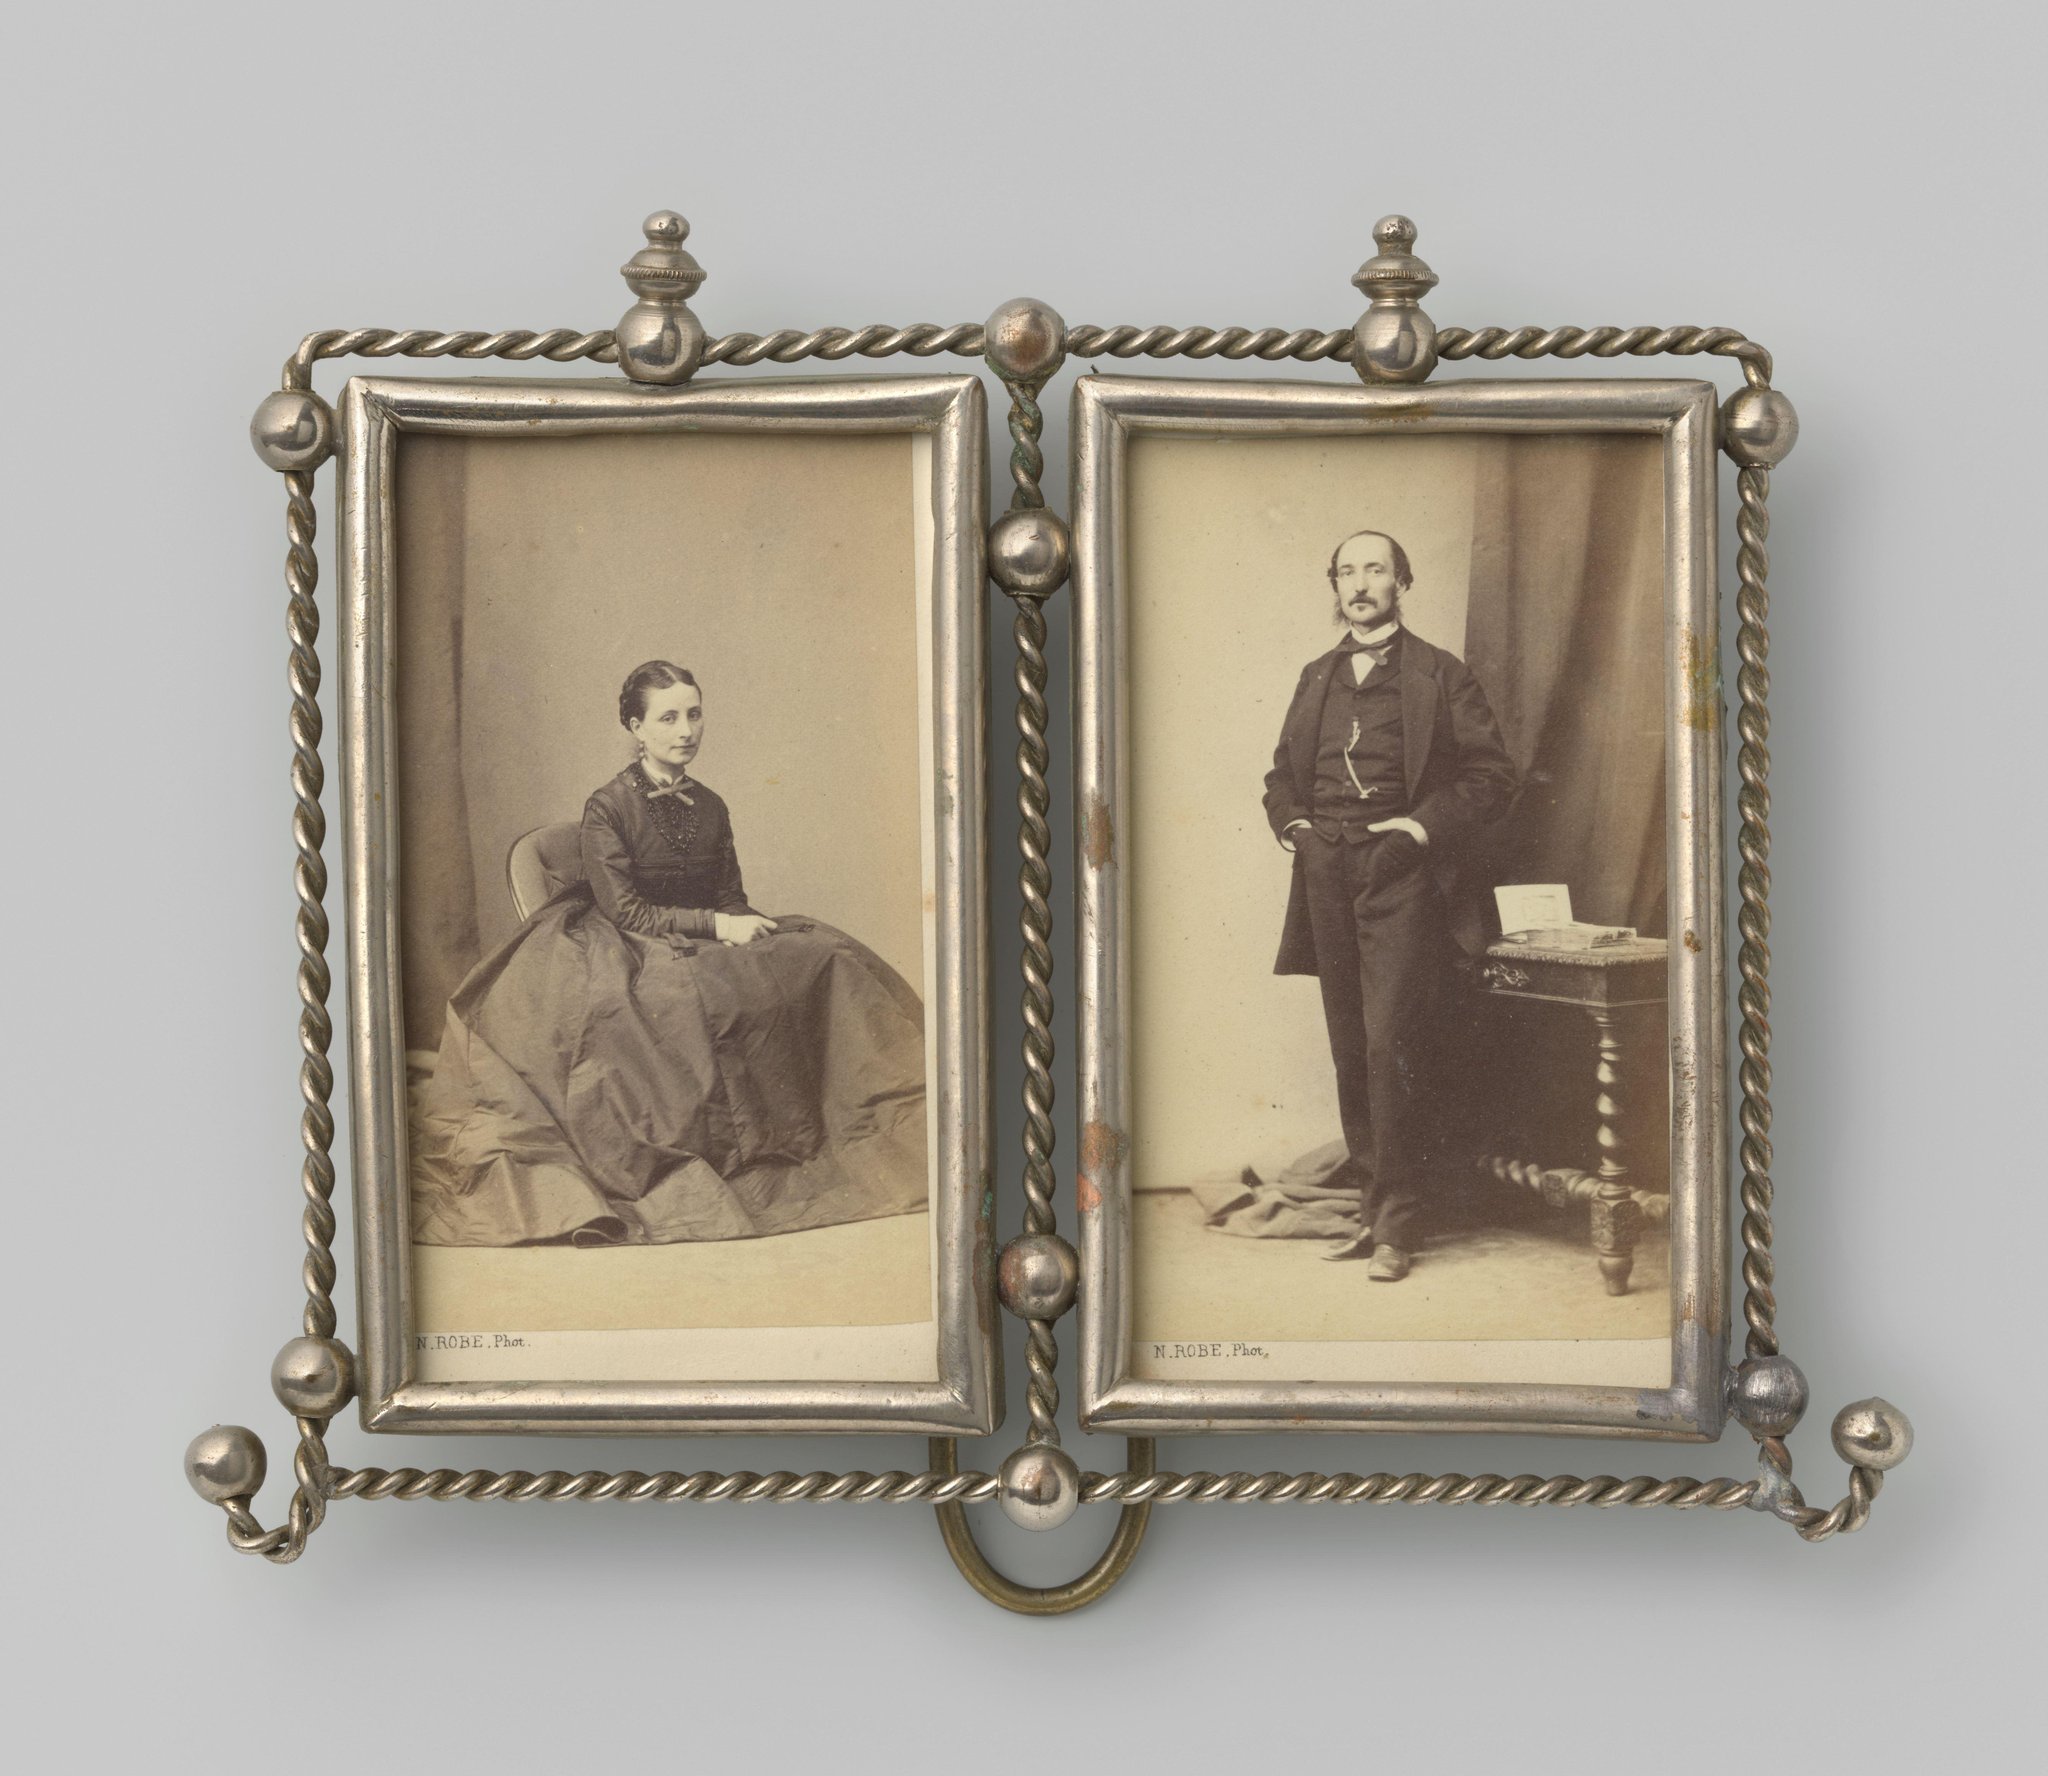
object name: photograph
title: Portret van een onbekende zittende vrouw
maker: n. robe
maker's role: fotograaf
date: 1855-1865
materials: cardboard, paper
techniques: albumen print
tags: adult woman, anonymous historical person portrayed